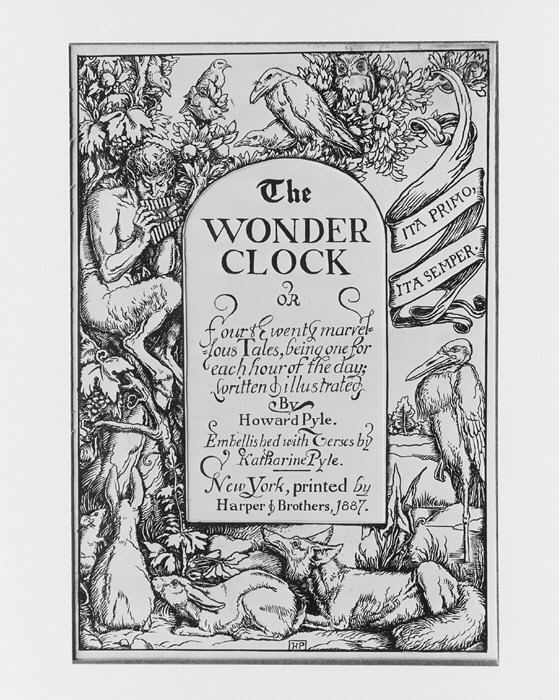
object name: drawing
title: Title Page for "The Wonder Clock, or Four & Twenty Marvelous Tales, Being One for Each Hour of the Day"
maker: howard pyle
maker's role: artist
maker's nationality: american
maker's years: 1853-1911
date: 1887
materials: ink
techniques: pen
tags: birds,foxes,rabbits